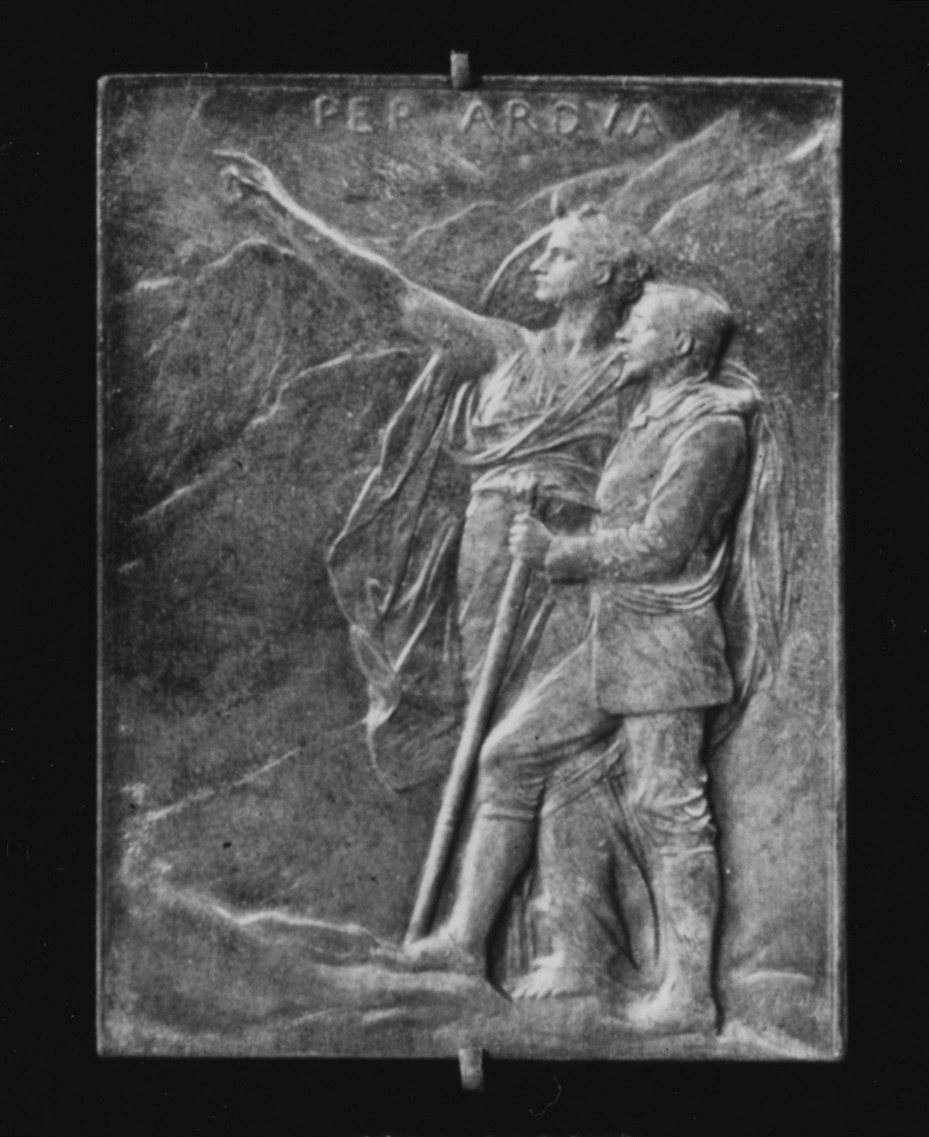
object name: plaquette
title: For the French Alpine Club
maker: louis-oscar roty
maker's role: artist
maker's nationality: french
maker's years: 1846-1911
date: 1801-1900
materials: bronze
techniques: silvered, struck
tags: men